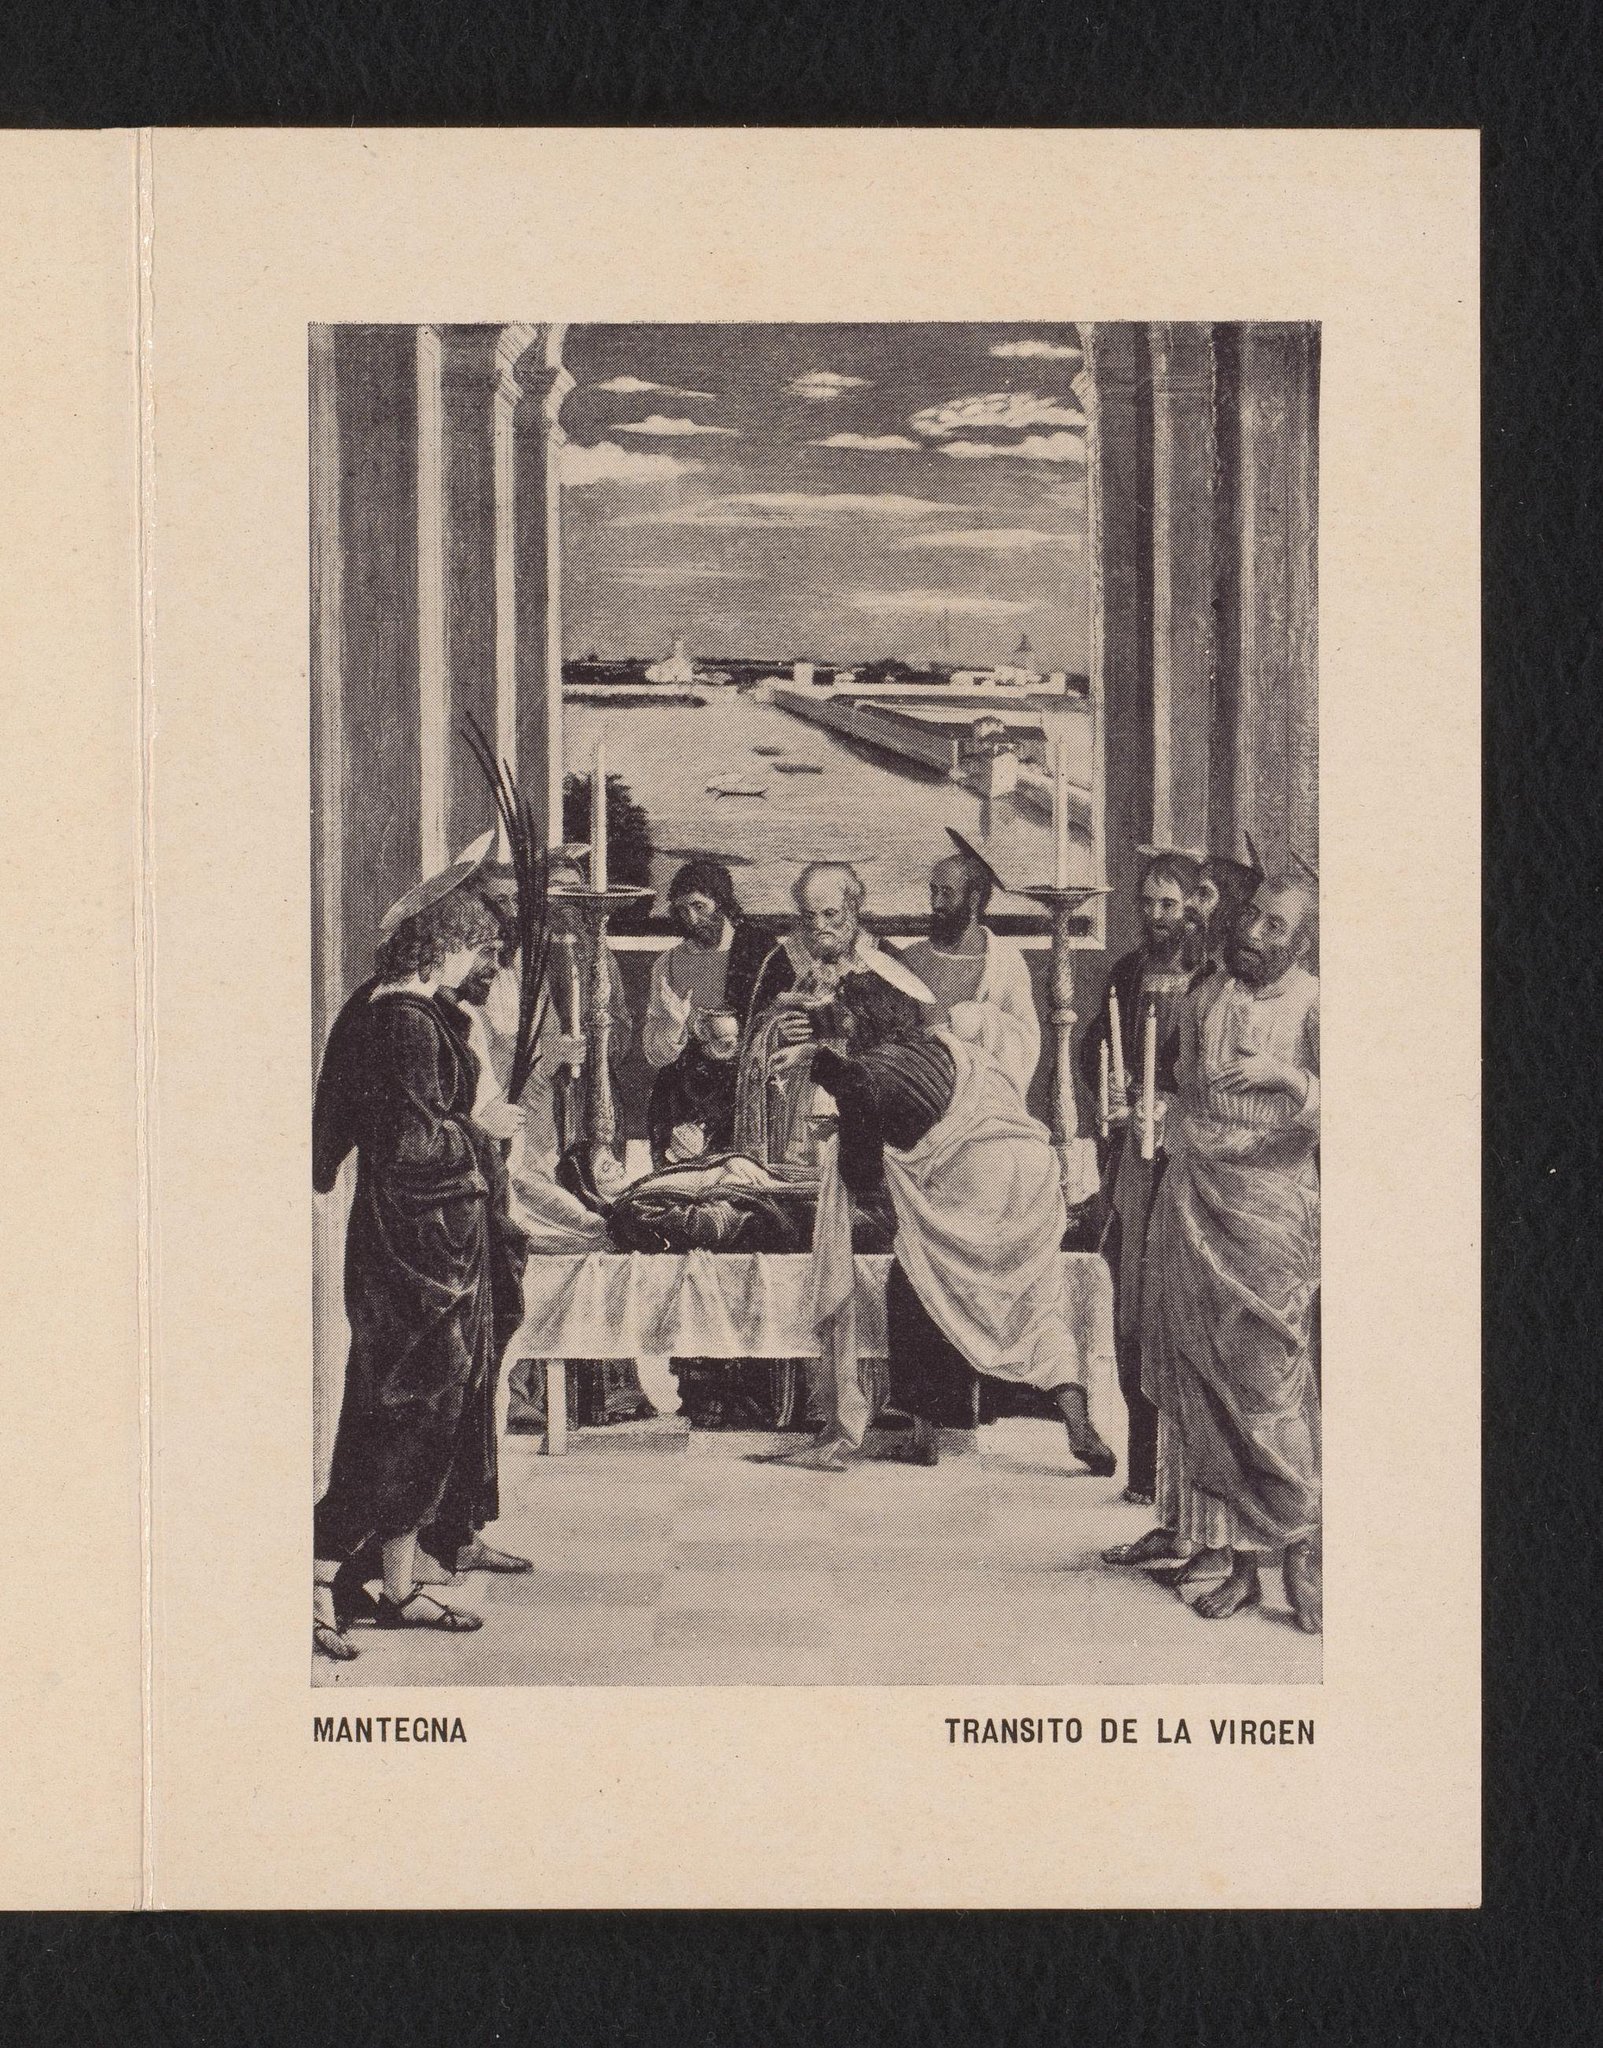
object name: ansichtkaart, prentbriefkaart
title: Mantegna. Transito de la virgen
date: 1910-1950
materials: cardboard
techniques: autotype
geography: madrid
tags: permanent exhibition, museum, picture, painting